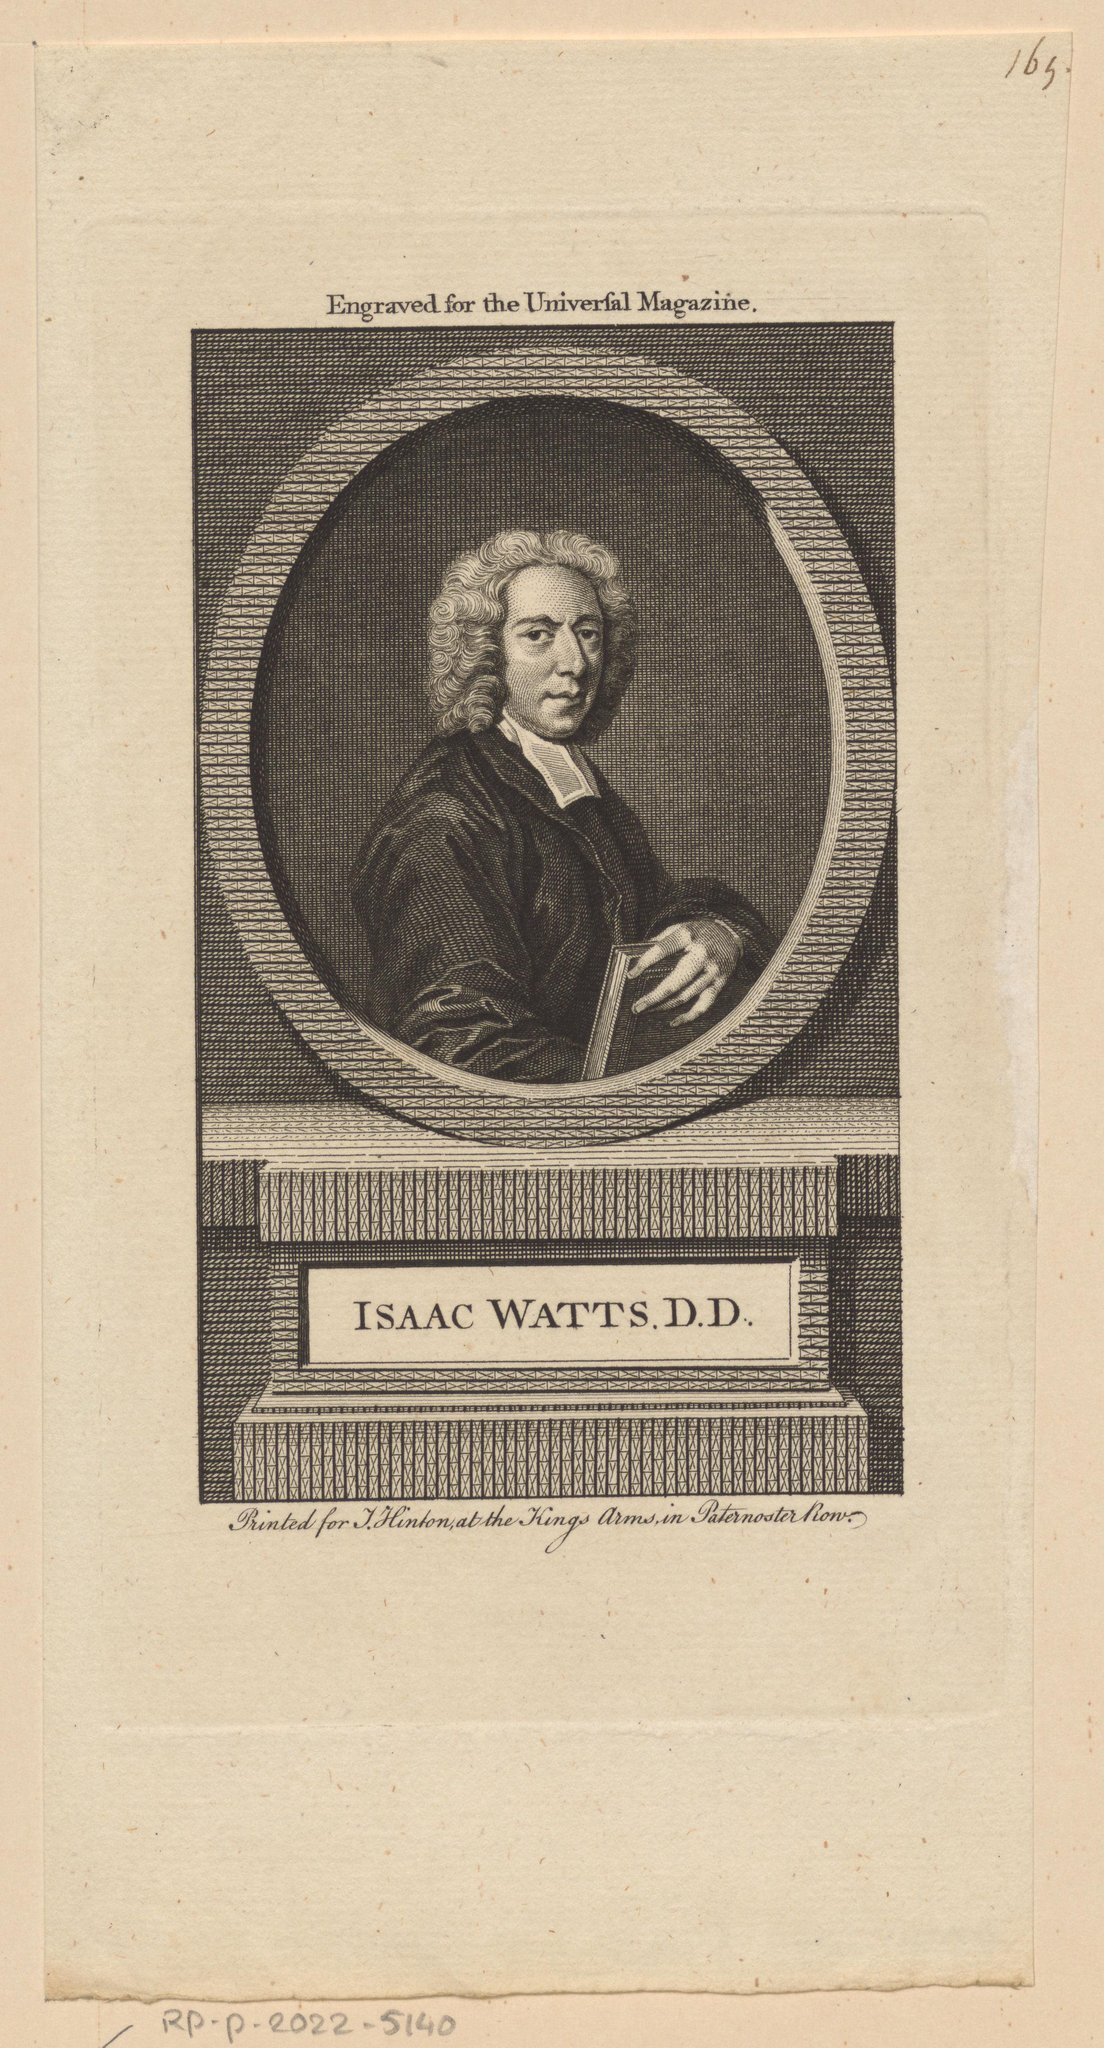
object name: print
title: Portret van Isaac Watts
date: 1780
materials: paper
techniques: engraving, etching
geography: london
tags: theologian, historical persons, portrait of a writer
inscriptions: number: ‘164’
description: Prent uit: The Universal Magazine, nr. 66, 1780.